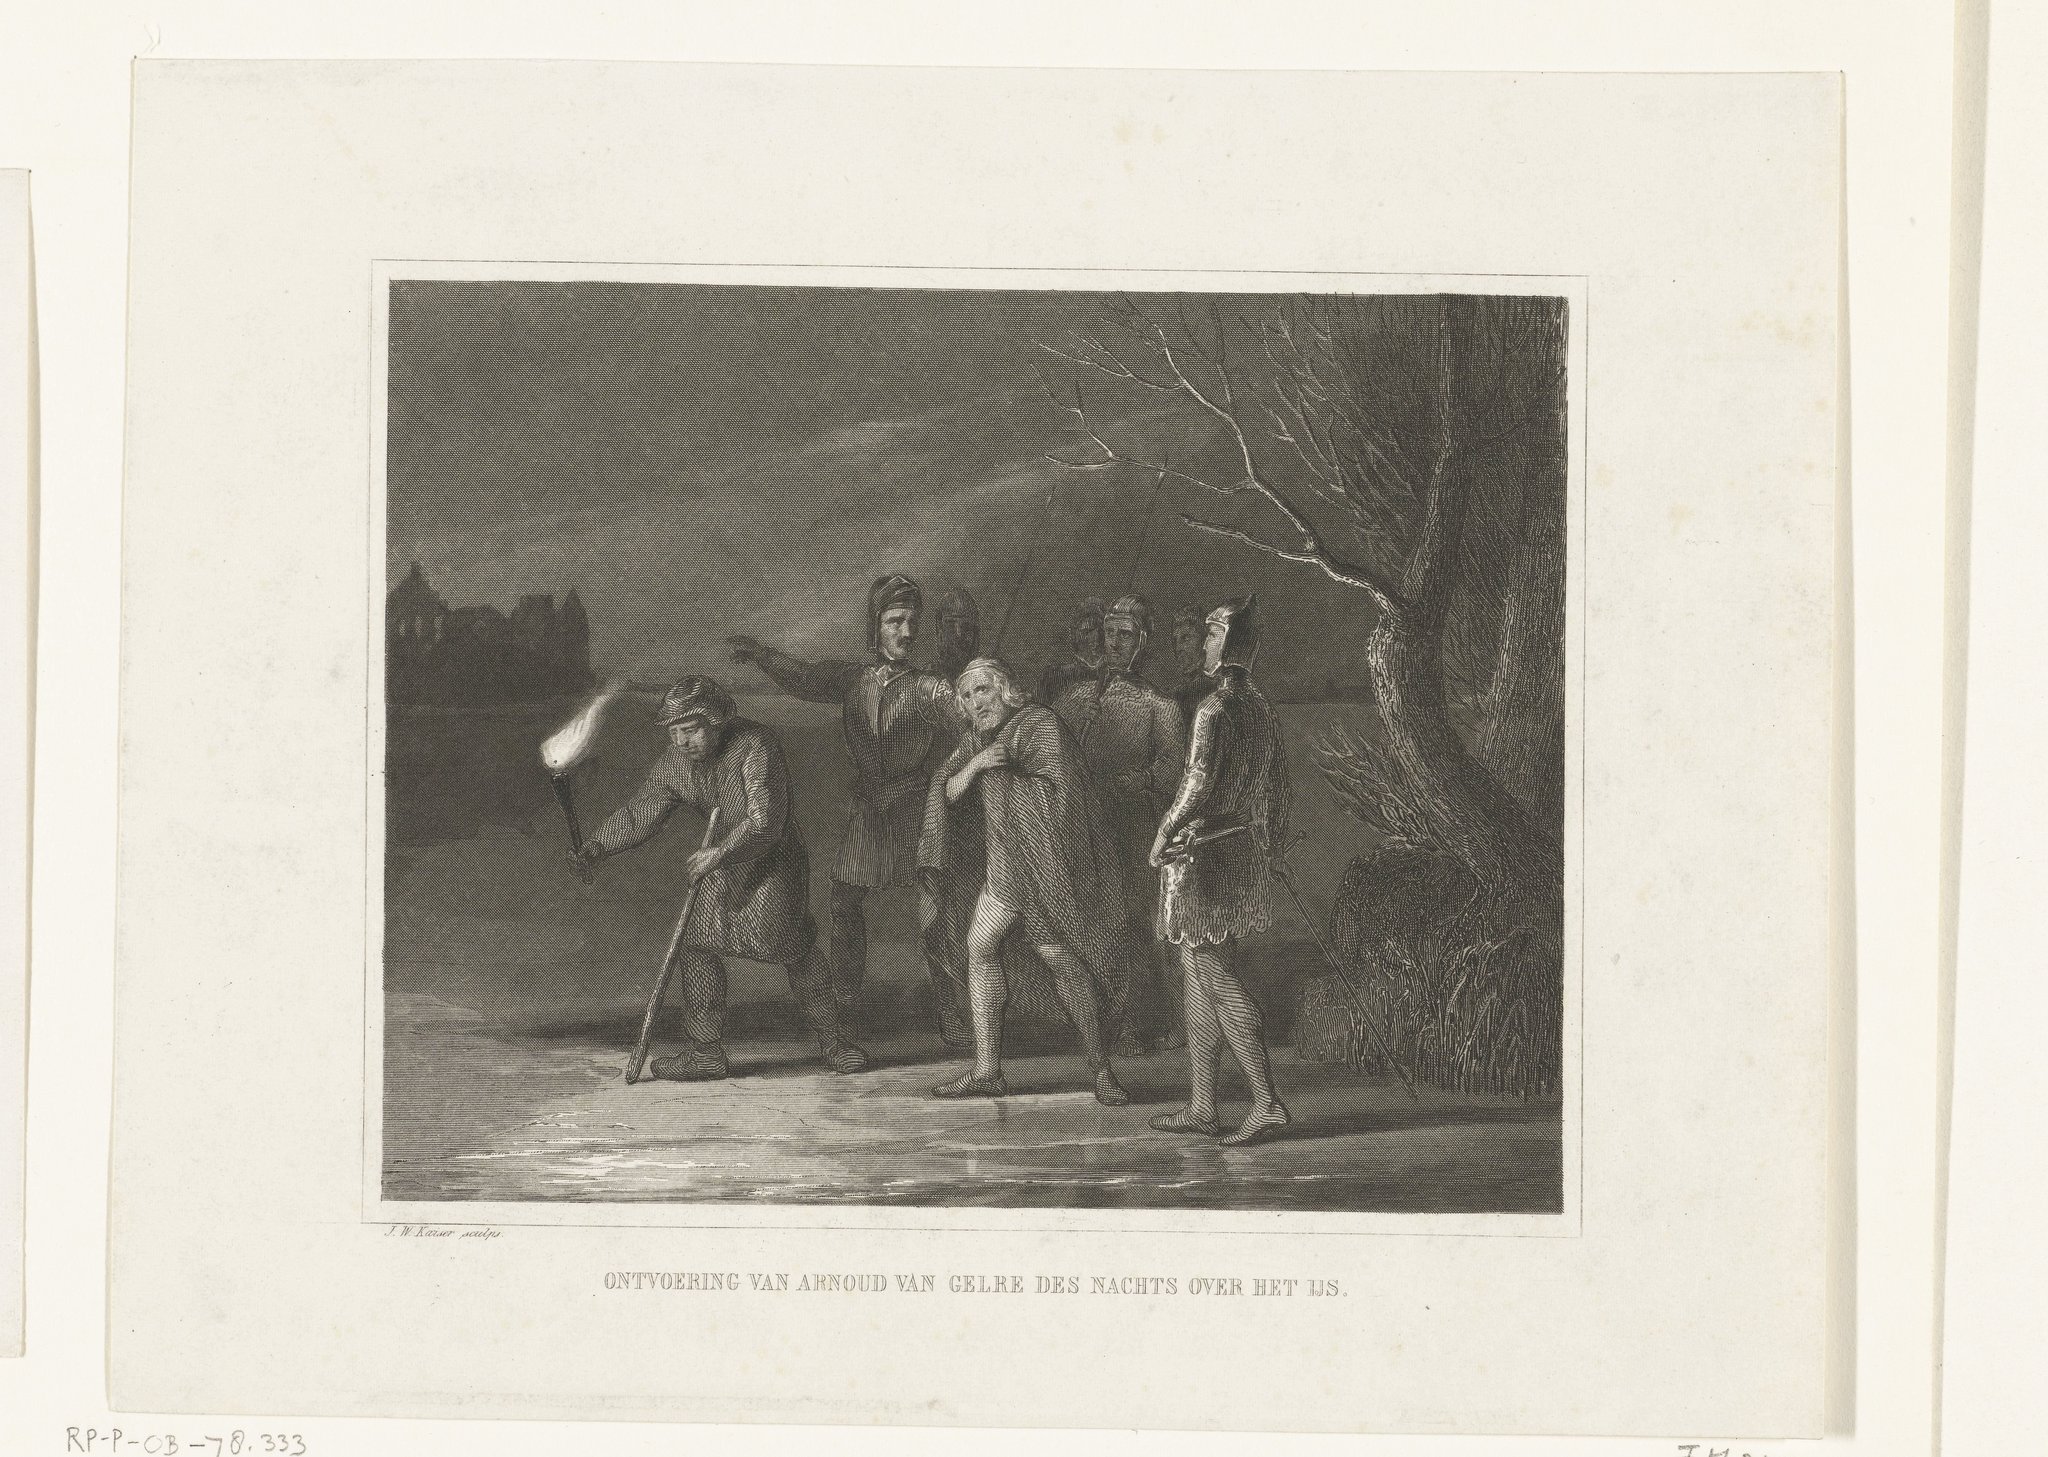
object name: history print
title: Hertog Arnold van Gelre door zijn zoon Adolf ontvoerd, 1465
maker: johann wilhelm kaiser (i)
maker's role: draughtsman, print maker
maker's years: 1813-1900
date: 1844-1846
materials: paper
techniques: engraving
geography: netherlands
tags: burgundian netherlands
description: Arnold van Egmond, hertog van Gelre door soldaten van zijn zoon Adolf ontvoerd en over het ijs naar het kasteel van Buren gevoerd en daar gedwongen afstand te doen van zijn rechten, 1465.